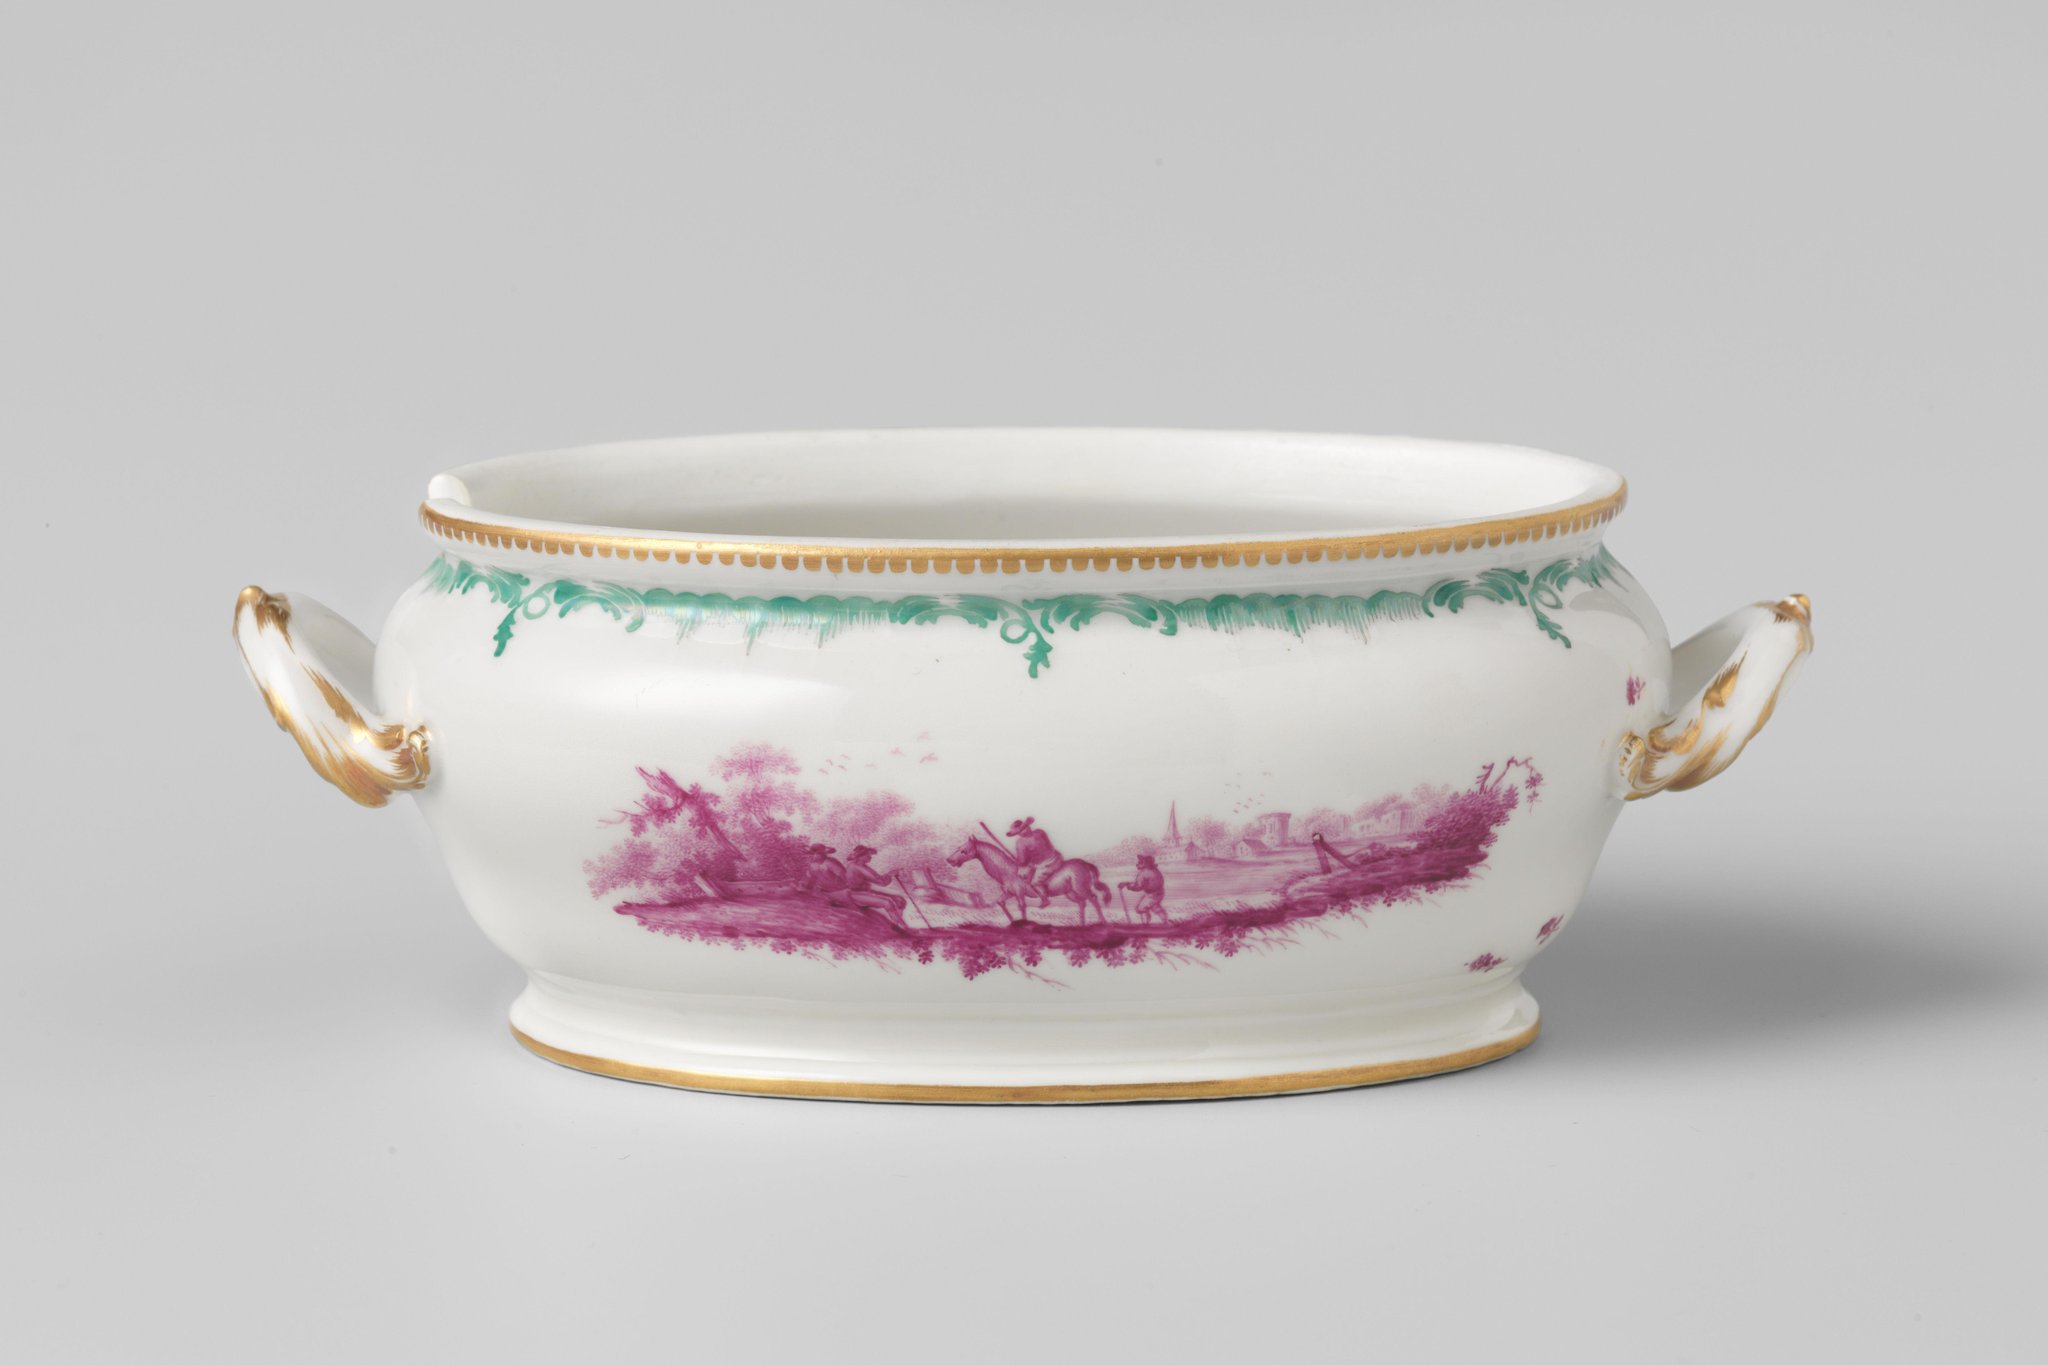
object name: tureen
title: Terrine, beschilderd met figuren in landschappen en enkele strooibloemen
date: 1782-1784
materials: porcelain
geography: loosdrecht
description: Terrinel van porselein. Ovaal met plastisch versierde oren. De randen zijn geschulpt. De randen zijn versierd met rocailleornament in reliëf, dat groen beschilderd is. Alle delen beschilderd in bietenrood met figuren in een landschap en met enkele strooibloempjes. Biezen met afhangend bladwerk in goud langs de randen. Oren en handvat versierd in goud. In de mondrand van de terrine een uitsparing voor een lepel.